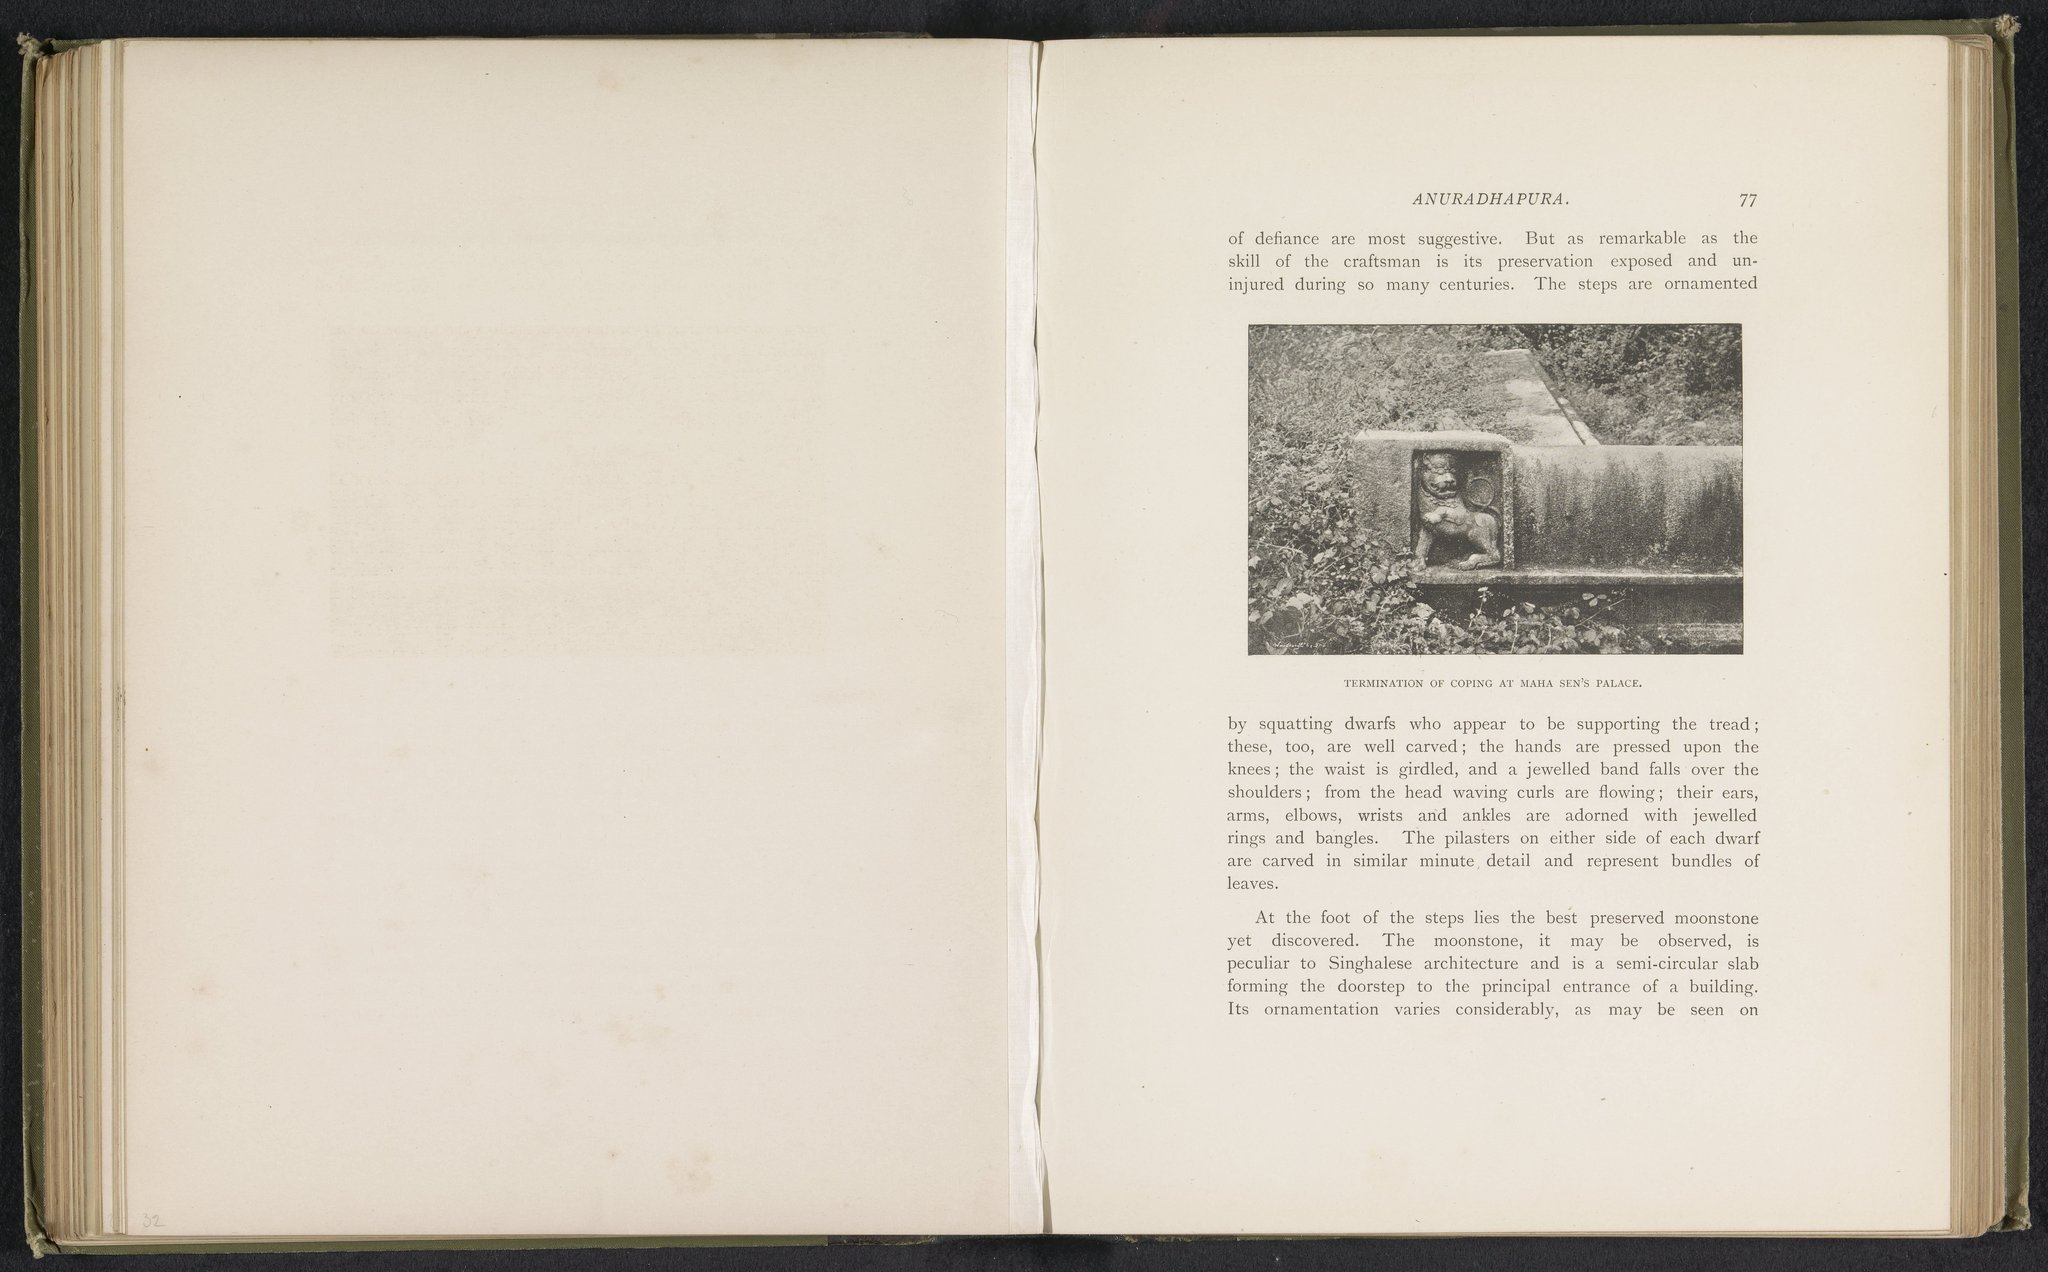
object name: photomechanical print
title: Relief depicting a lion in the wall coping of the palace of King Mahasena at Anuradhapura, Sri Lanka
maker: henry william cave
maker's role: fotograaf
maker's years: 1854-1913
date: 1896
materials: paper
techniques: autotype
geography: anuradhapura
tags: beasts of prey, predatory animals: lion, sculpture (+ relief ~ sculpture)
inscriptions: title: ‘TERMINATION OF COPING AT MAHA SEN'S PALACE.’, signature: ‘Woodbury P [?]’